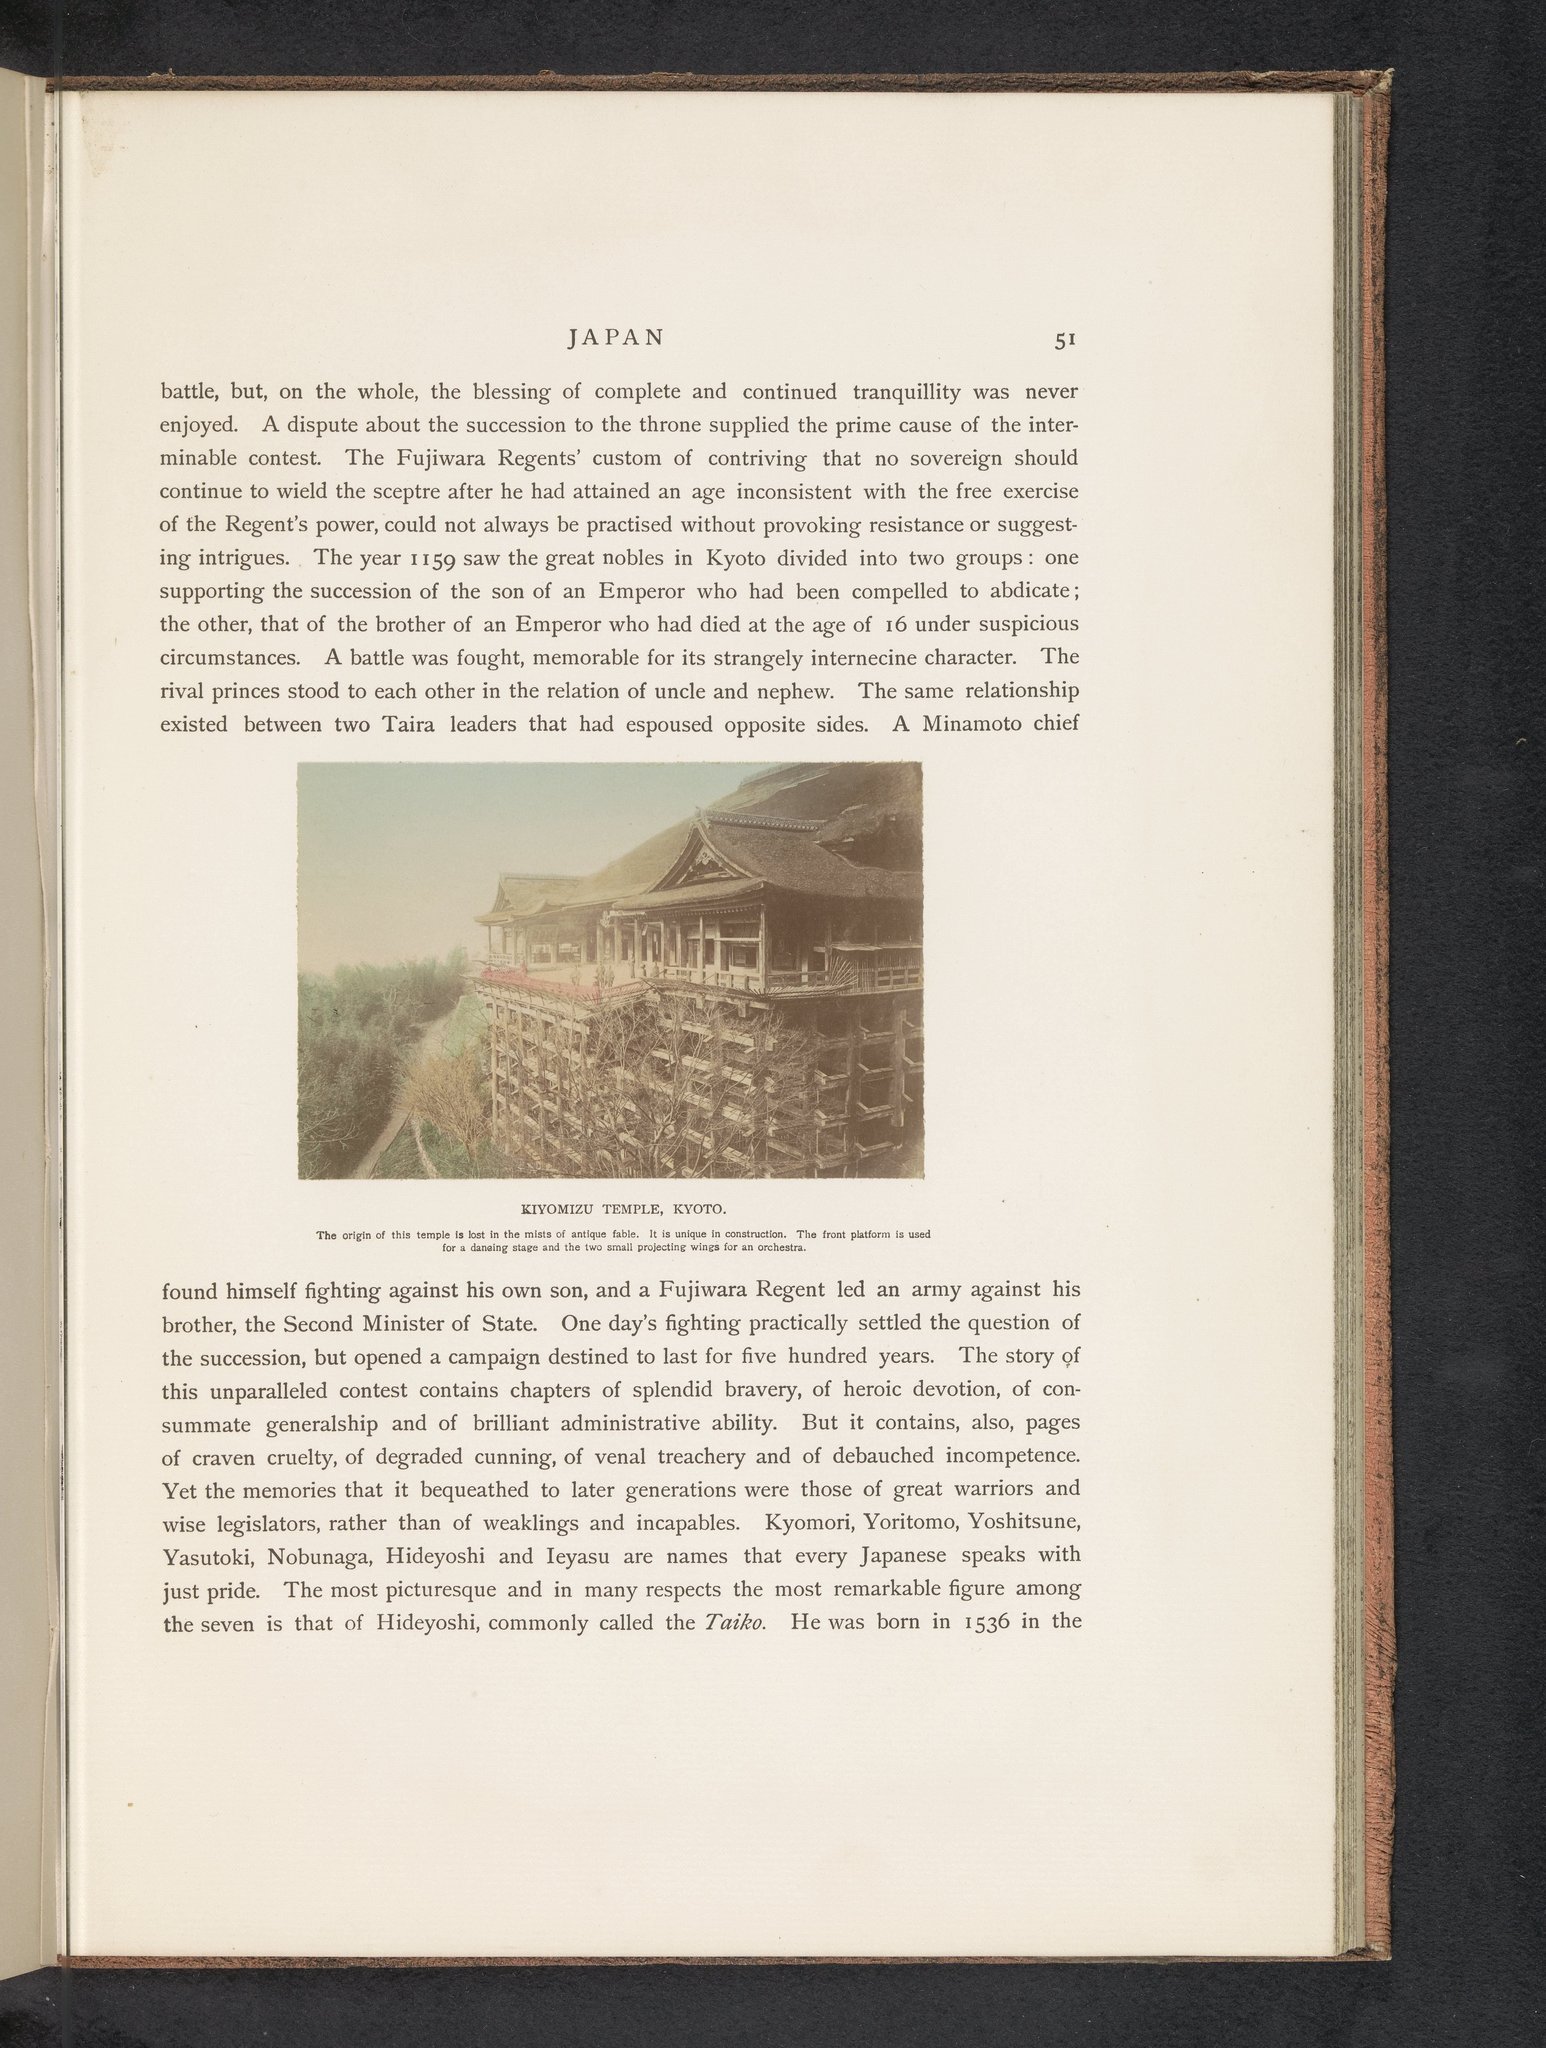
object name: photograph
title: Gevel van de tempel Kiyomizu-dera te Kyoto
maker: Anonymous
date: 1887-1897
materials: photographic support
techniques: albumen print, hand coloring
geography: kyoto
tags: temple, shrine ~ hinduism, buddhism, jainism, façade (of house or building)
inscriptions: inscription: ‘The origin of this temple (...) the two small projecting wings for an orchestra.’